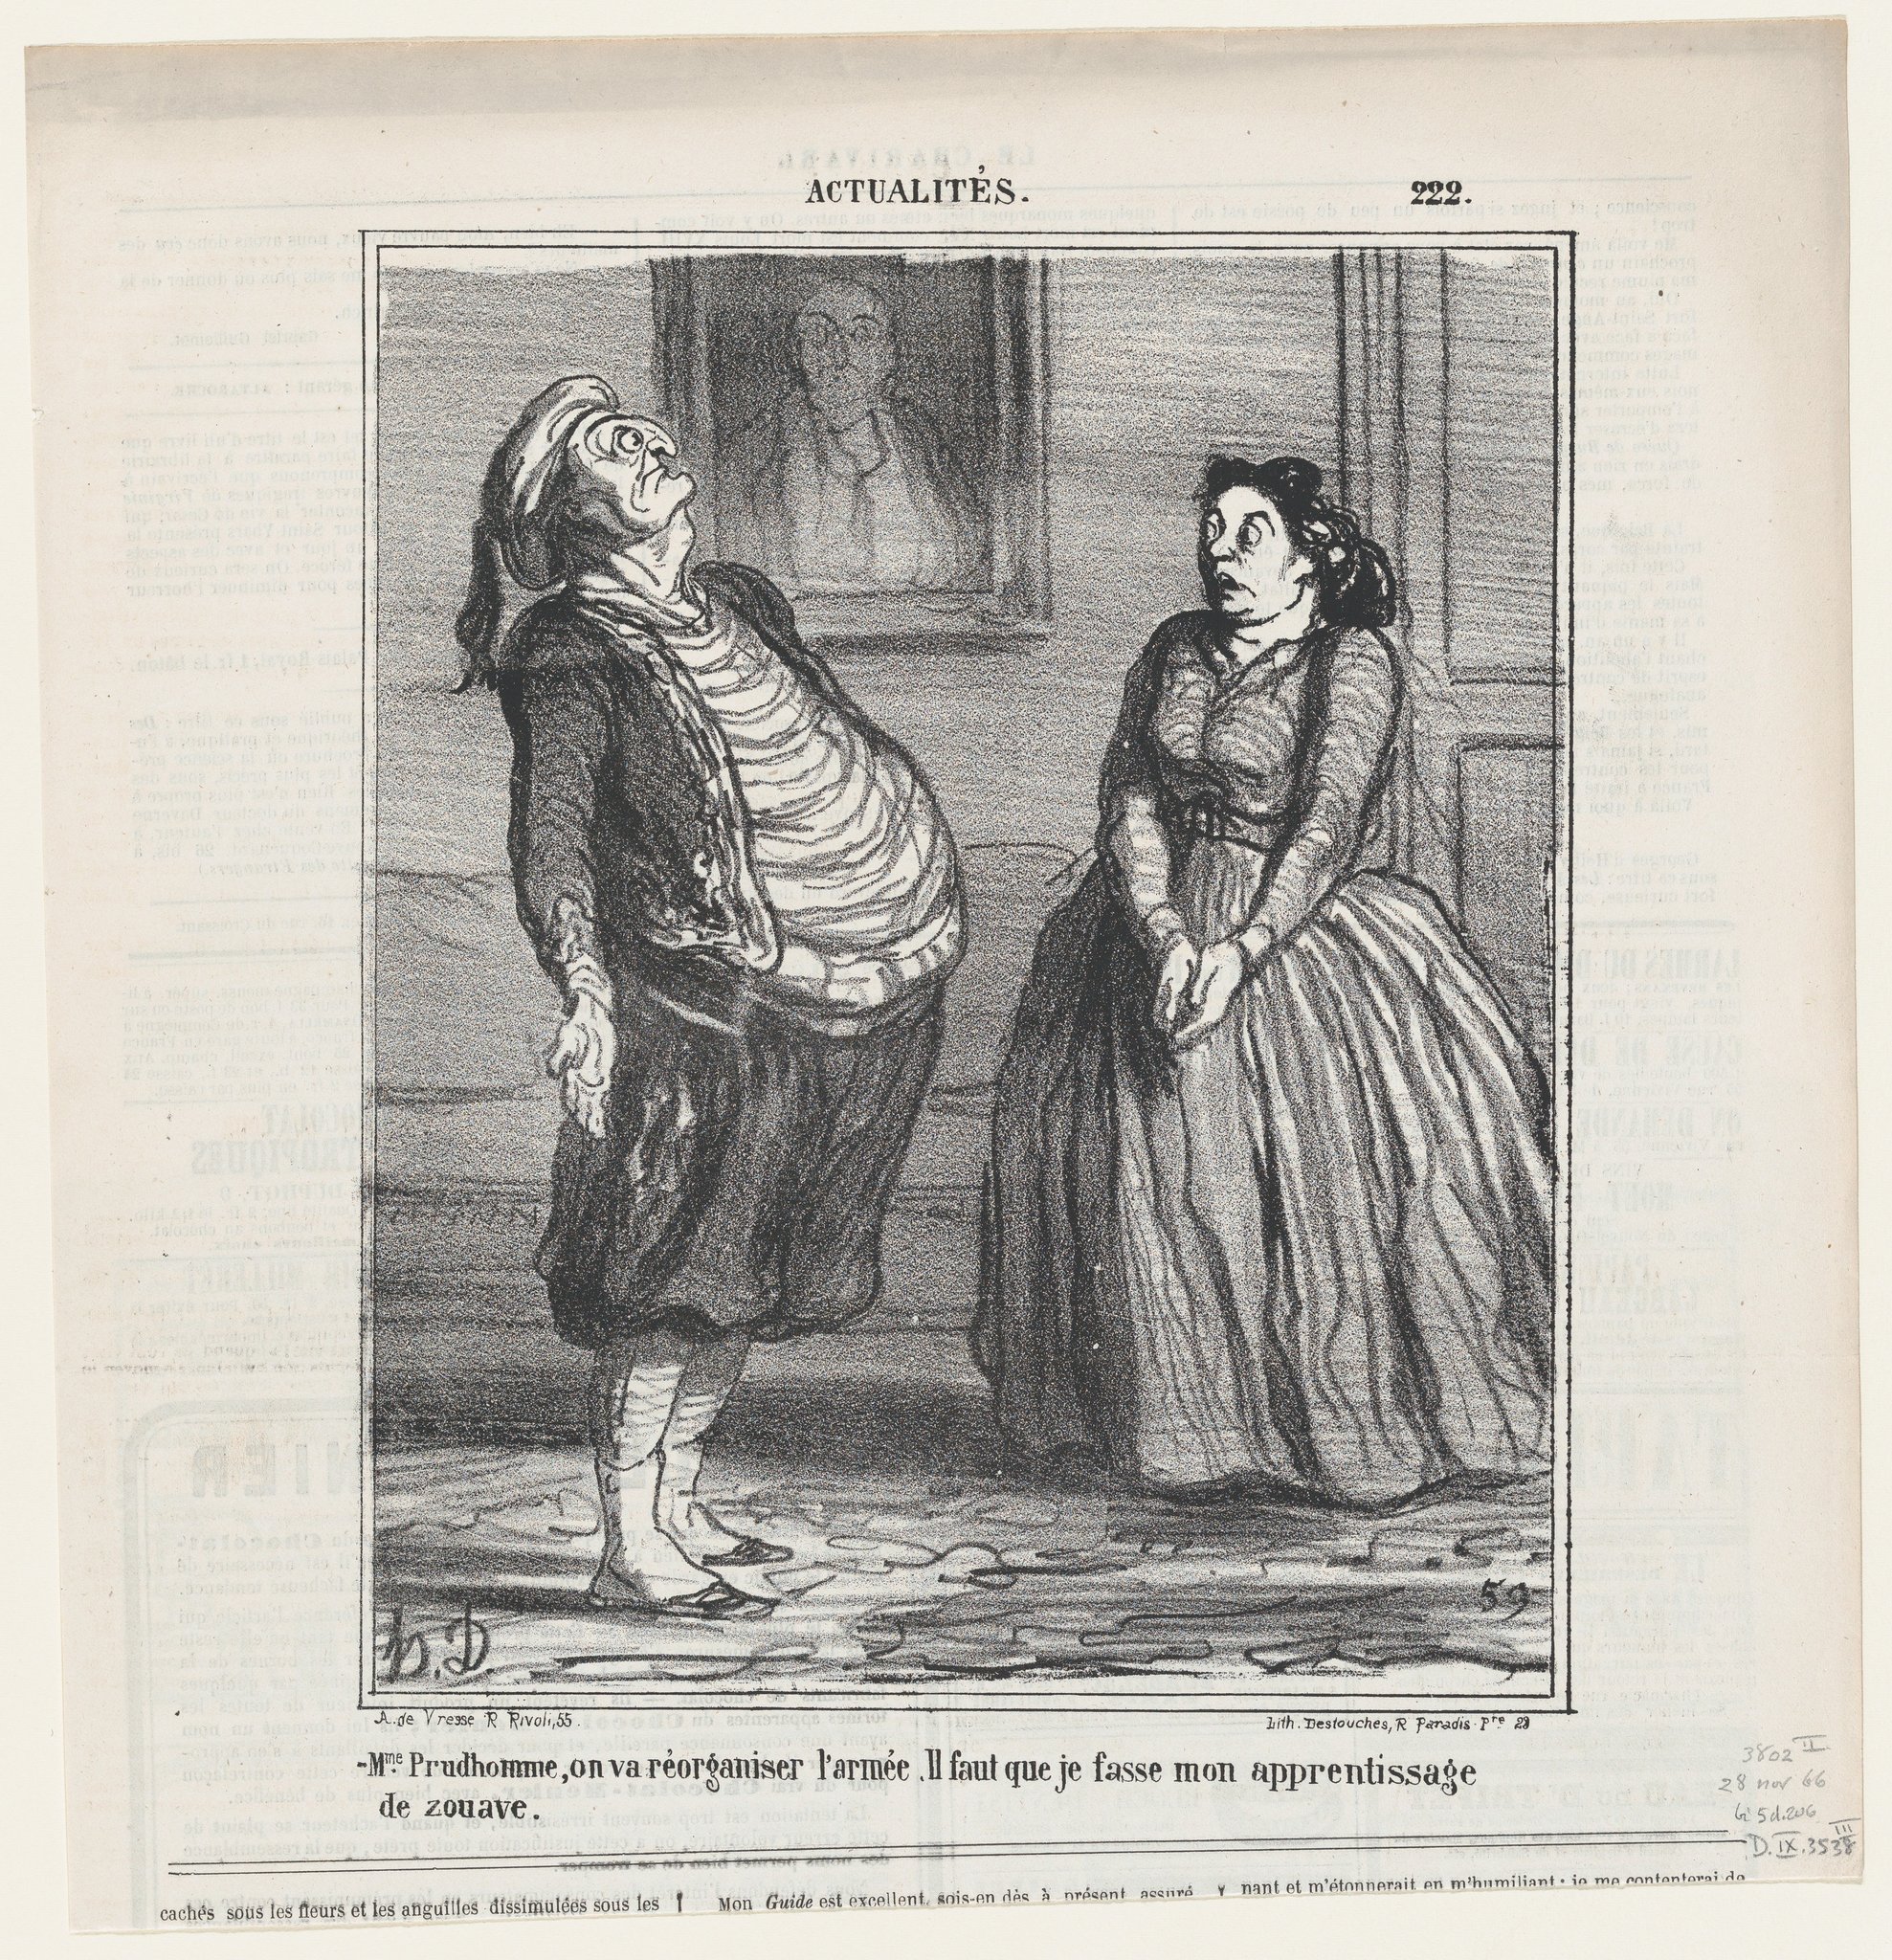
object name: print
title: Madame Prudhomme, they are reorganizing the army. It is only right that I serve my duty as a Zouave, from 'News of the day,' published in Le Charivari, November 28, 1866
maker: honoré daumier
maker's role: artist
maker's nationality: french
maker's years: 1808-1879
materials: paper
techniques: lithograph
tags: satire,men,women